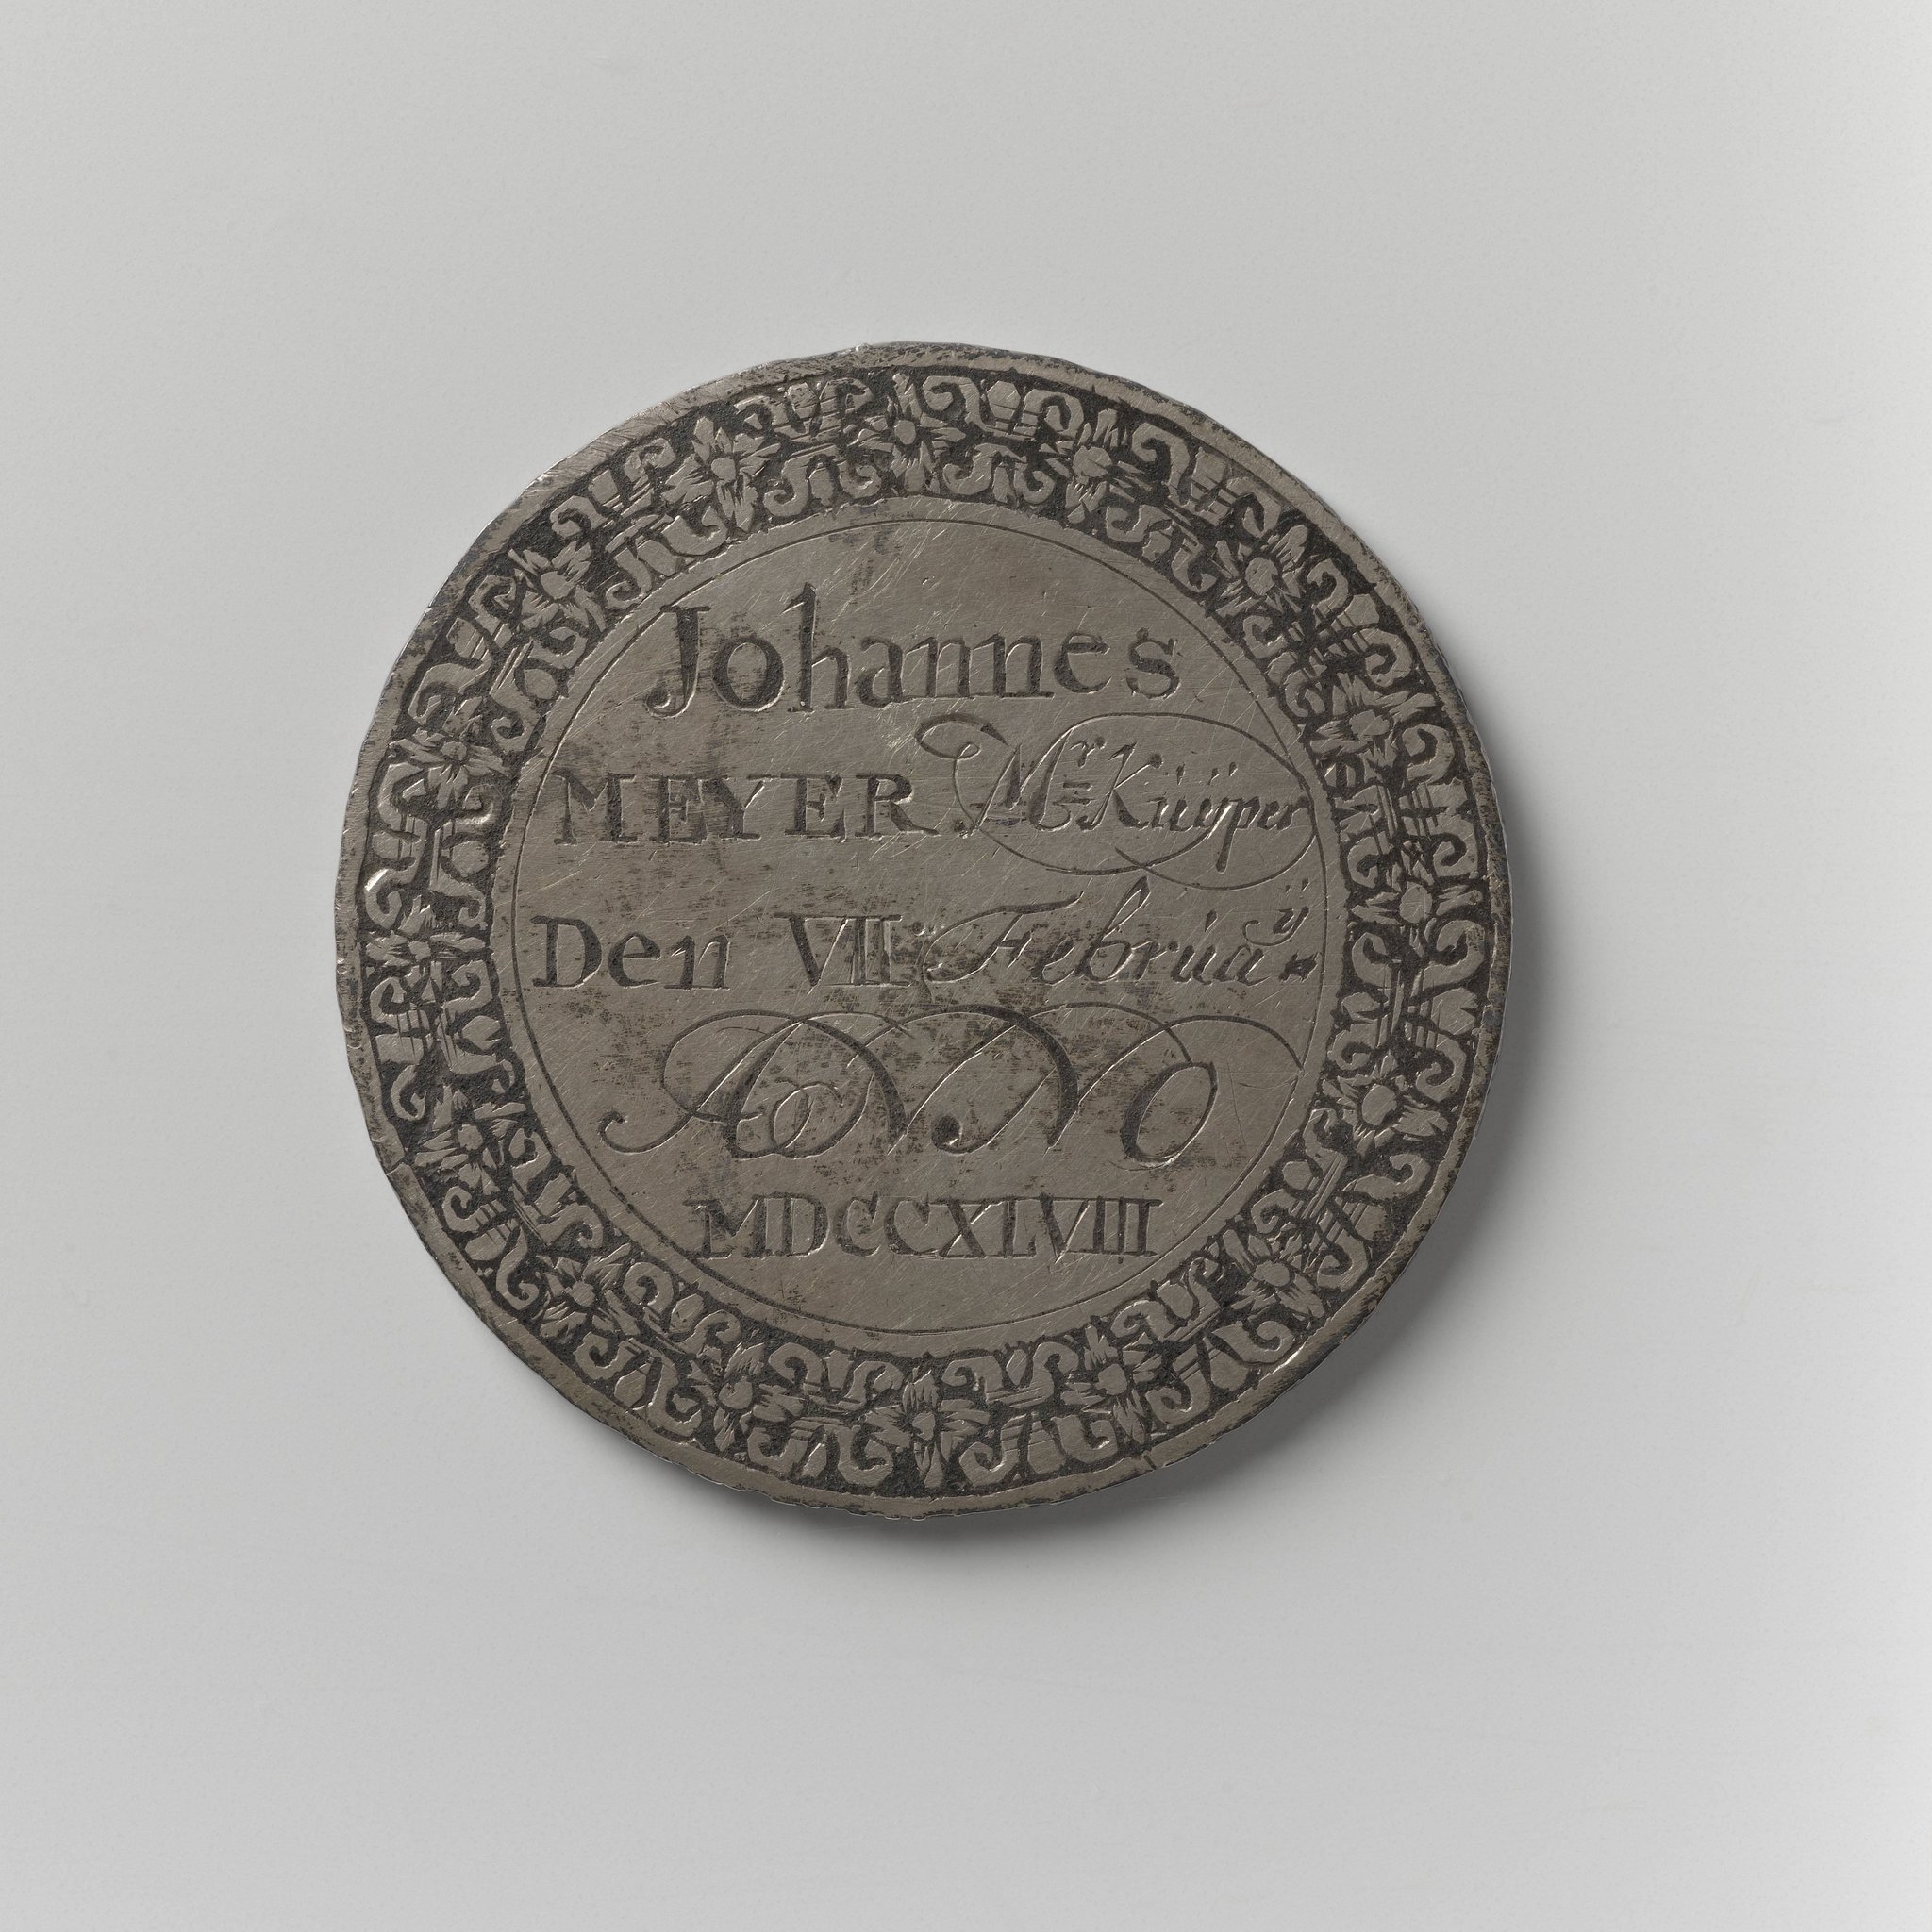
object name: medal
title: Kuipers- en wijnverlatersgilde van Amsterdam, gildepenning op naam van Johannes Meyer, meester kuiper sinds 1748, overman sinds 1774.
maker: Anonymous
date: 1774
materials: silver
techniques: engraving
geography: amsterdam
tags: johannes meyer, amsterdam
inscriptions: inscription: ‘Johannes / MEYER Mr Kuijper / Den VII Februa ij / ANNO / MDCCXLVIII’, edge inscription: ‘DECVS . ET . TVTAMEN . ANNO . I . REGNI . VICESIMO . SECVNDO . I .’, circumscription: ‘* OVERMAN Geworden Den 17 Juny Ao 1774’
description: Zilveren penning. Voorzijde: opschrift binnen sierrand van bloemen en bladeren. Keerzijde: passer en dissel binnen bladerkrans en omschrift. De penning is gegraveerd over een compleet vlakgevijlde Engelse crown (uit 1748 van George II of uit 1670 van Charles II), waarvan alleen het randschrift nog resteert.